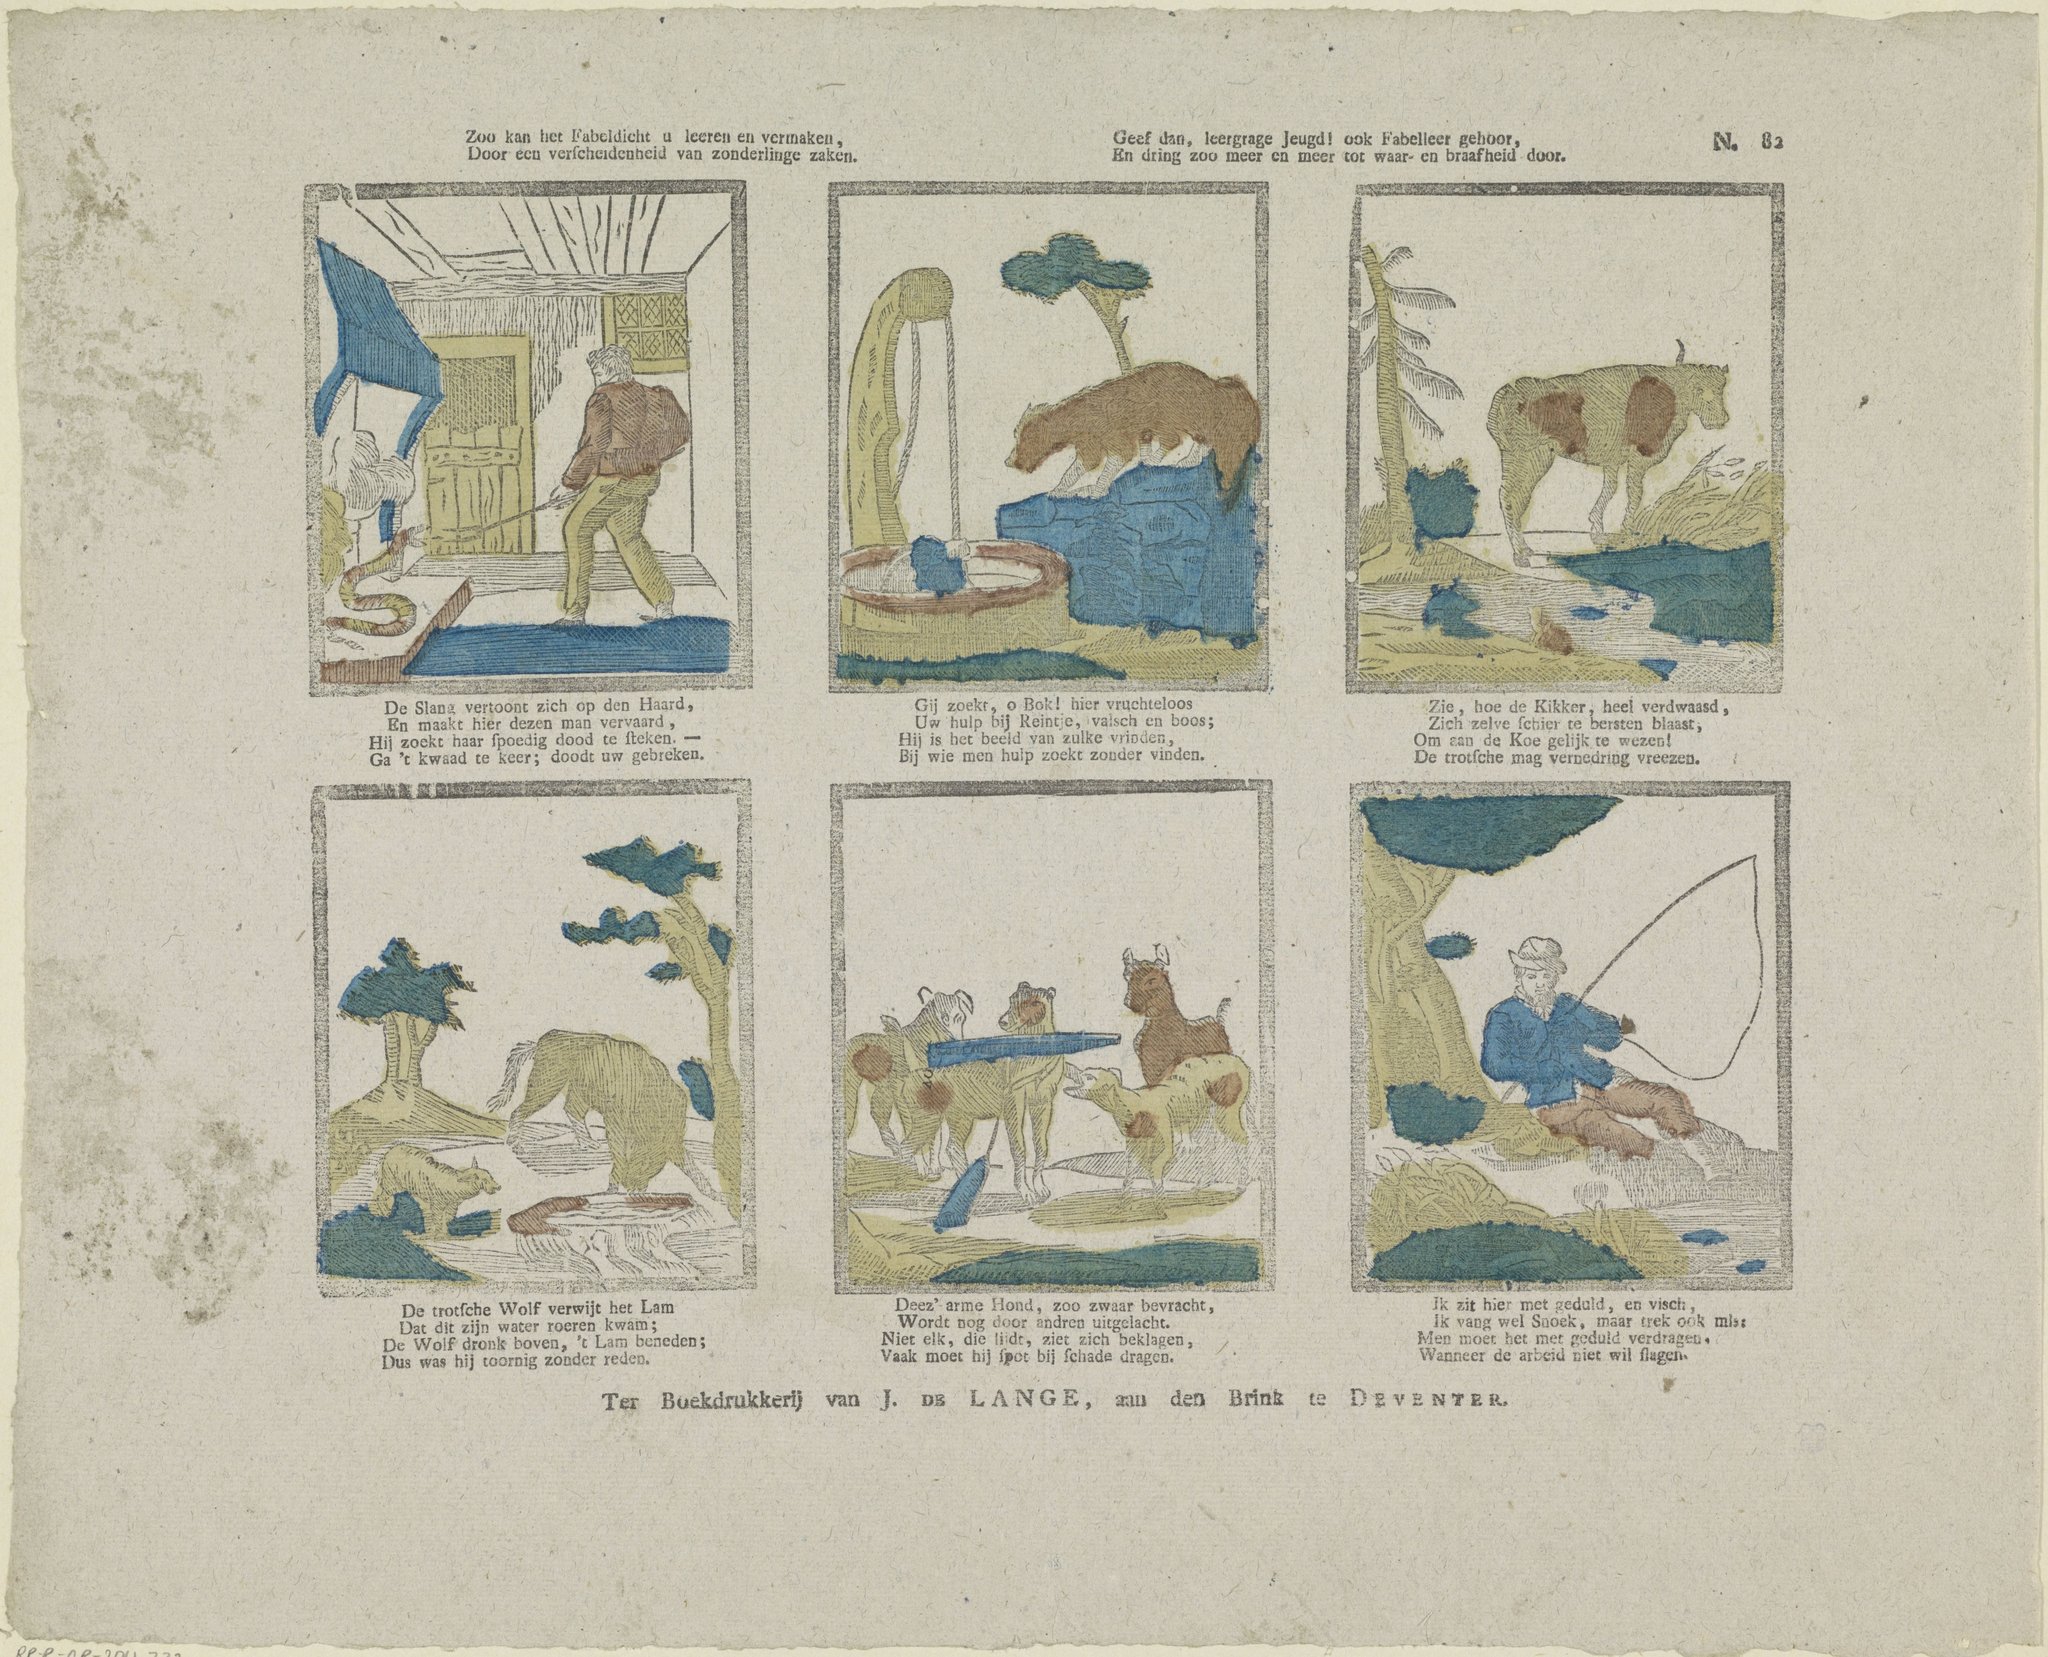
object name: print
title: Zoo kan het fabeldicht u leeren en vermaken, / Door een verscheidenheid van zonderlinge zaken. / Geef dan, leergrage jeugd! ook fabelleer gehoor, / En dring zoo meer en meer tot waar- en braafheid door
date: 1822-1849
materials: paper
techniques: colour, letterpress printing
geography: netherlands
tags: 'mundus inversus', the reversed world, the topsy-turvy world, 'le monde bestourné', fables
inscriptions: collector's mark: Lugt 2760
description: Blad met 6 voorstellingen van fabels. Onder elke afbeelding een vierregelig vers. Genummerd rechtsboven: N. 82.